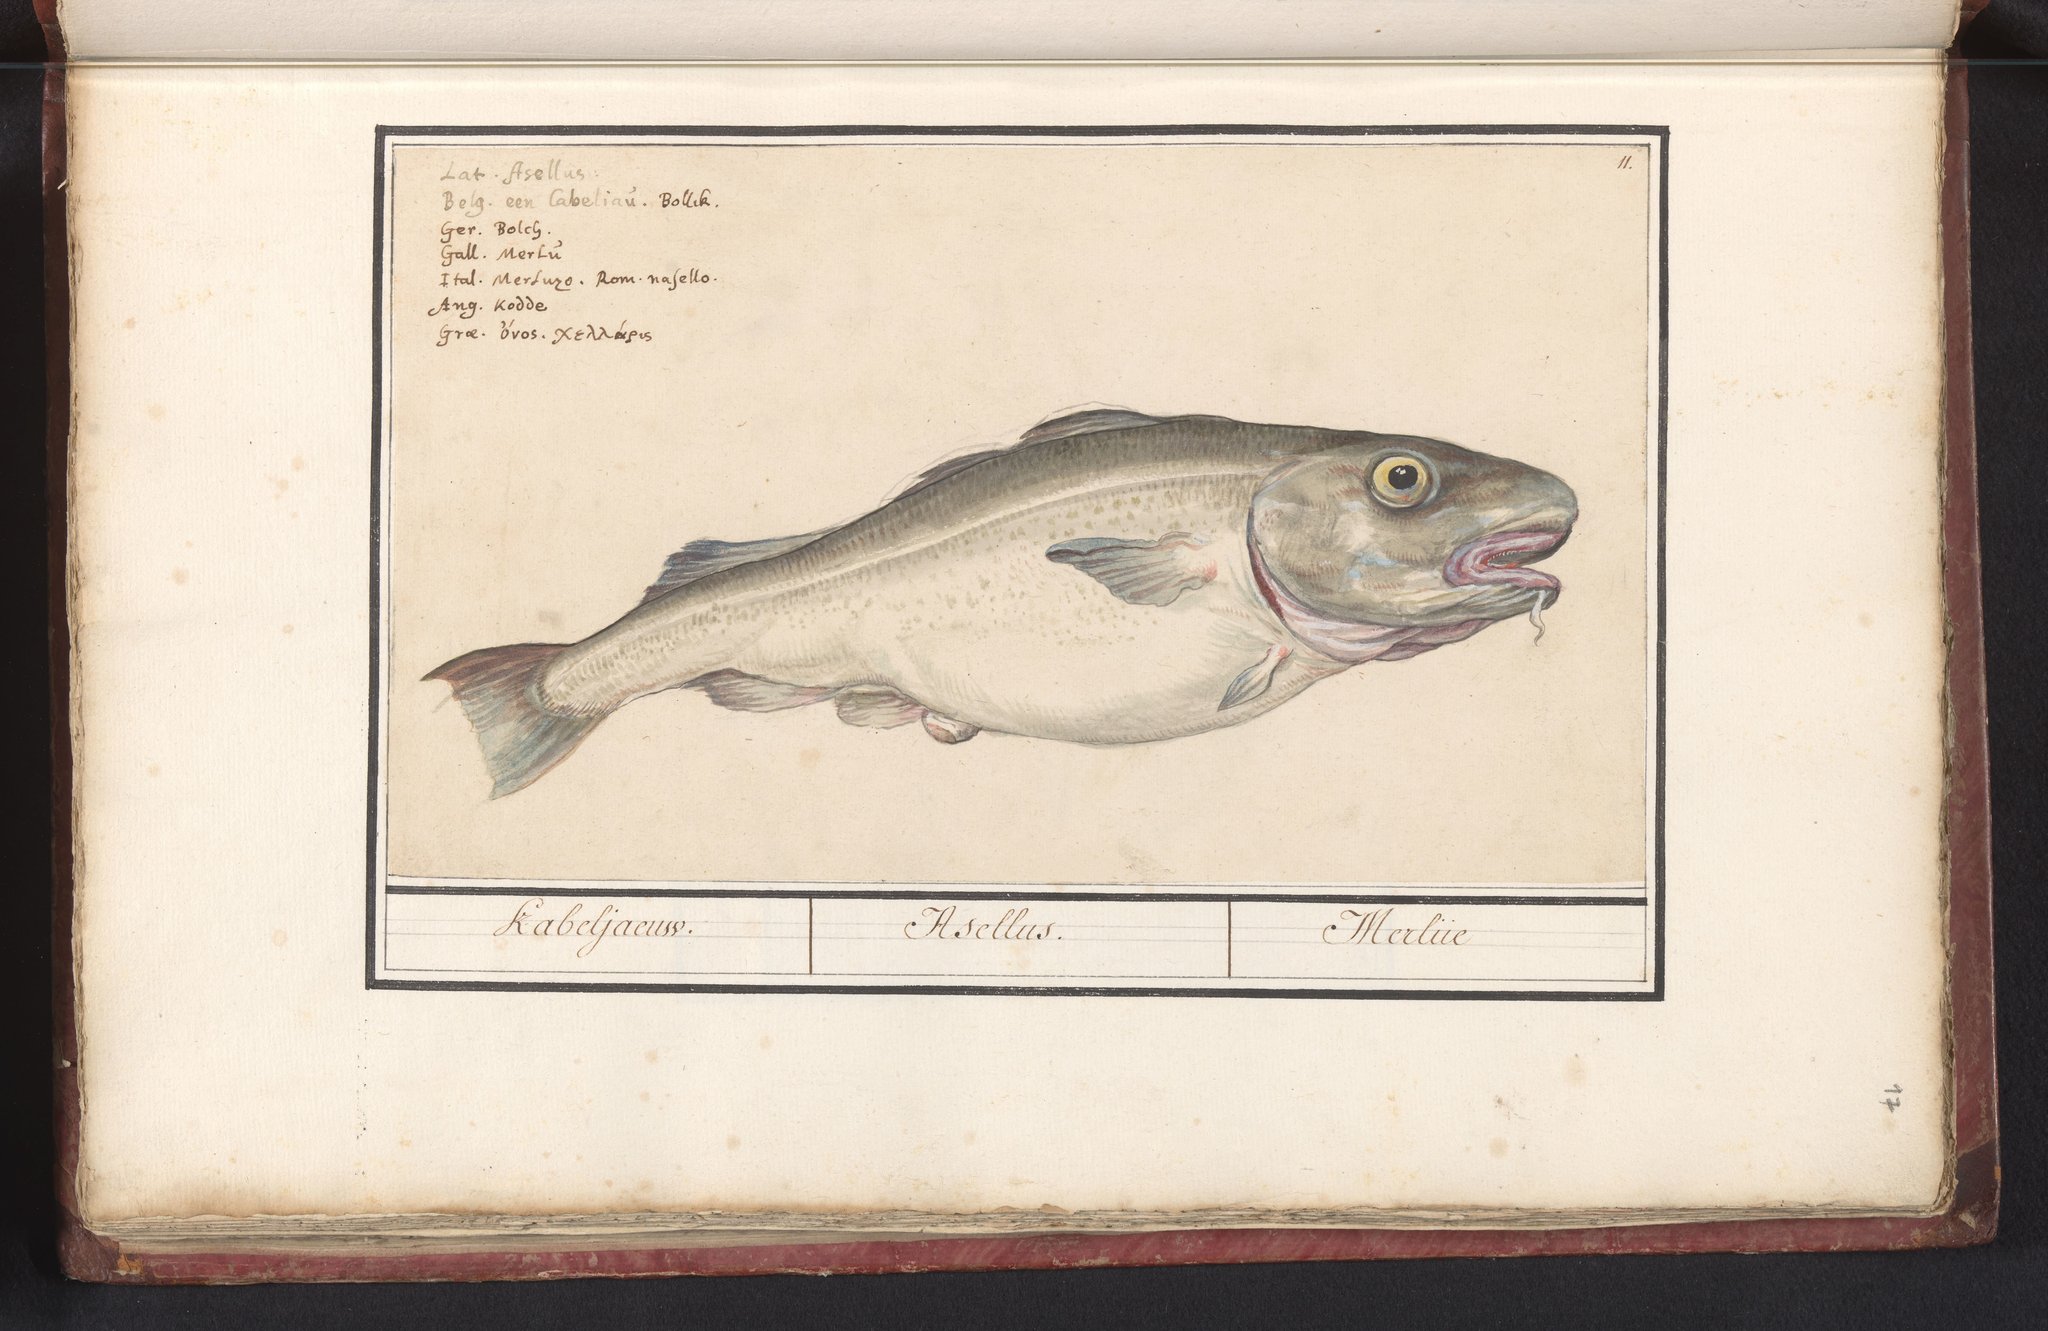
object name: drawing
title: Kabeljauw (Gadus morhua)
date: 1596-1610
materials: chalk, paint, ink, paper, pencil, watercolor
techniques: brush, pen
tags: bony fishes: cod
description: Kabeljauw. Genummerd rechtsboven: 11. Linksboven de naam in zeven talen. Onderdeel van het zesde album met tekeningen van vissen, schelpen en insekten. Zesde van twaalf albums met tekeningen van dieren, vogels en planten bekend rond 1600, gemaakt in opdracht van keizer Rudolf II. Met toelichting in Nederlands, Latijn en Frans.